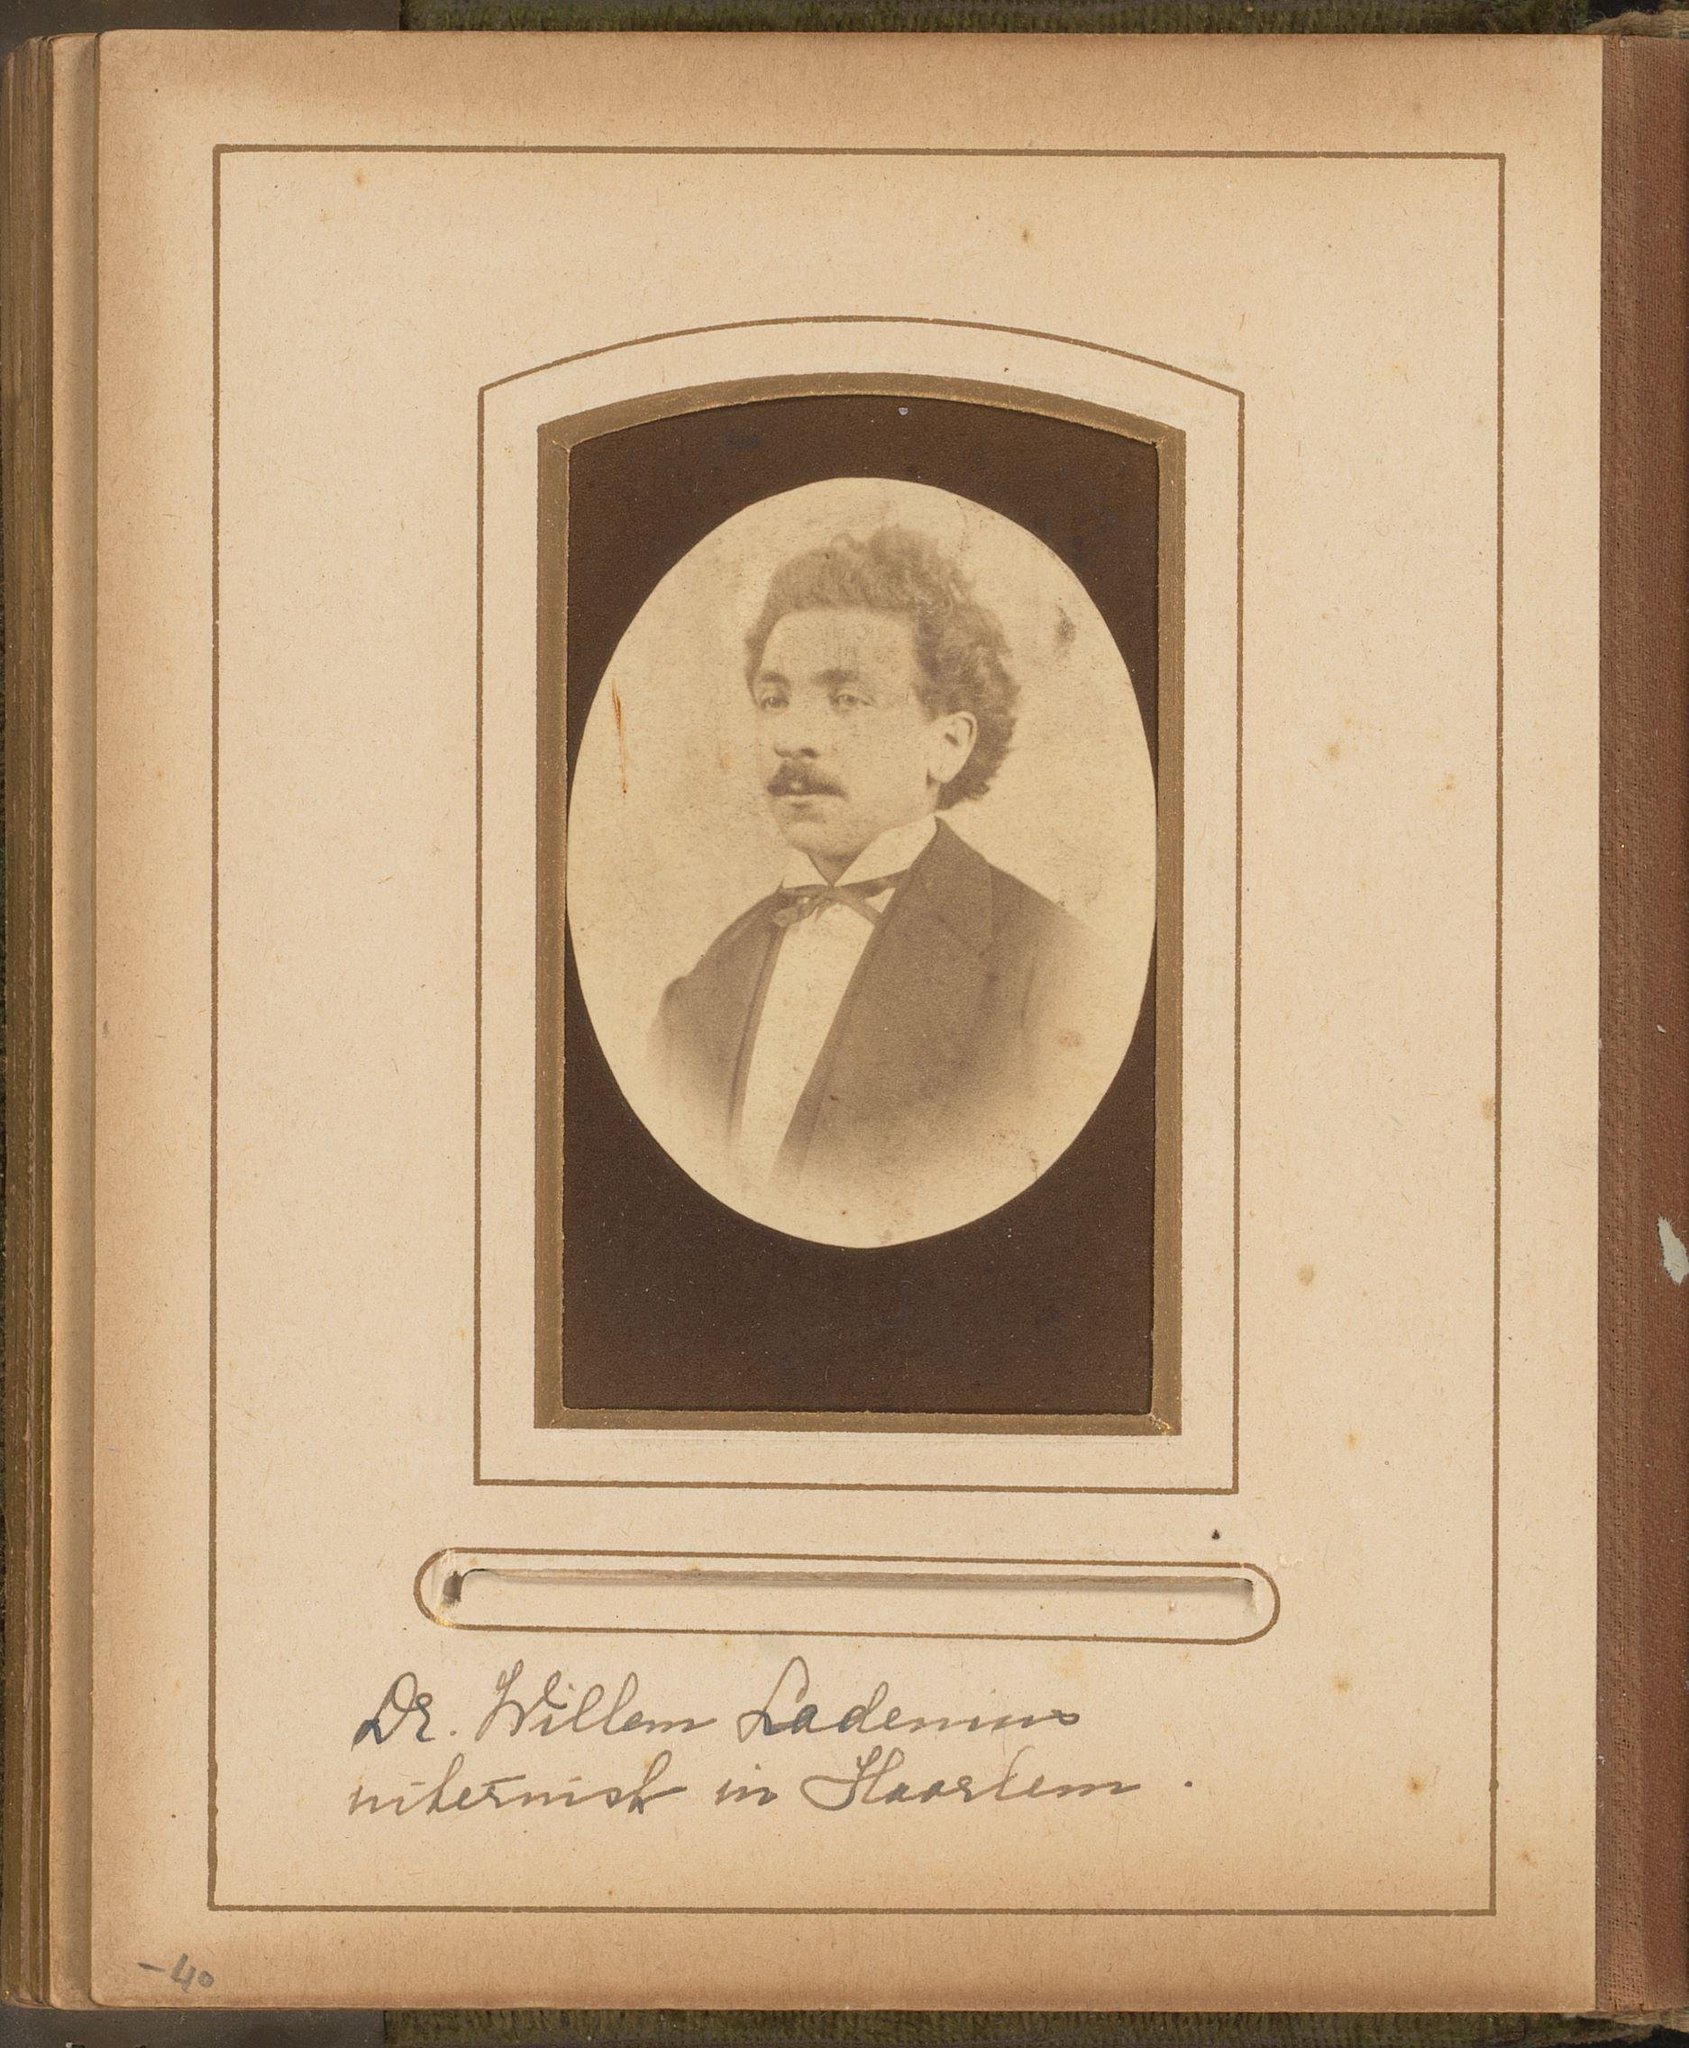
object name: carte de visite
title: Portret van een man, aangeduid als Willem Ladenius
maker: Anonymous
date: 1854-1885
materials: cardboard, paper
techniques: albumen print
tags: adult man, anonymous historical person portrayed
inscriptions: inscription: ‘Dr. Willem Ladenius/ [...] in Haarlem.’